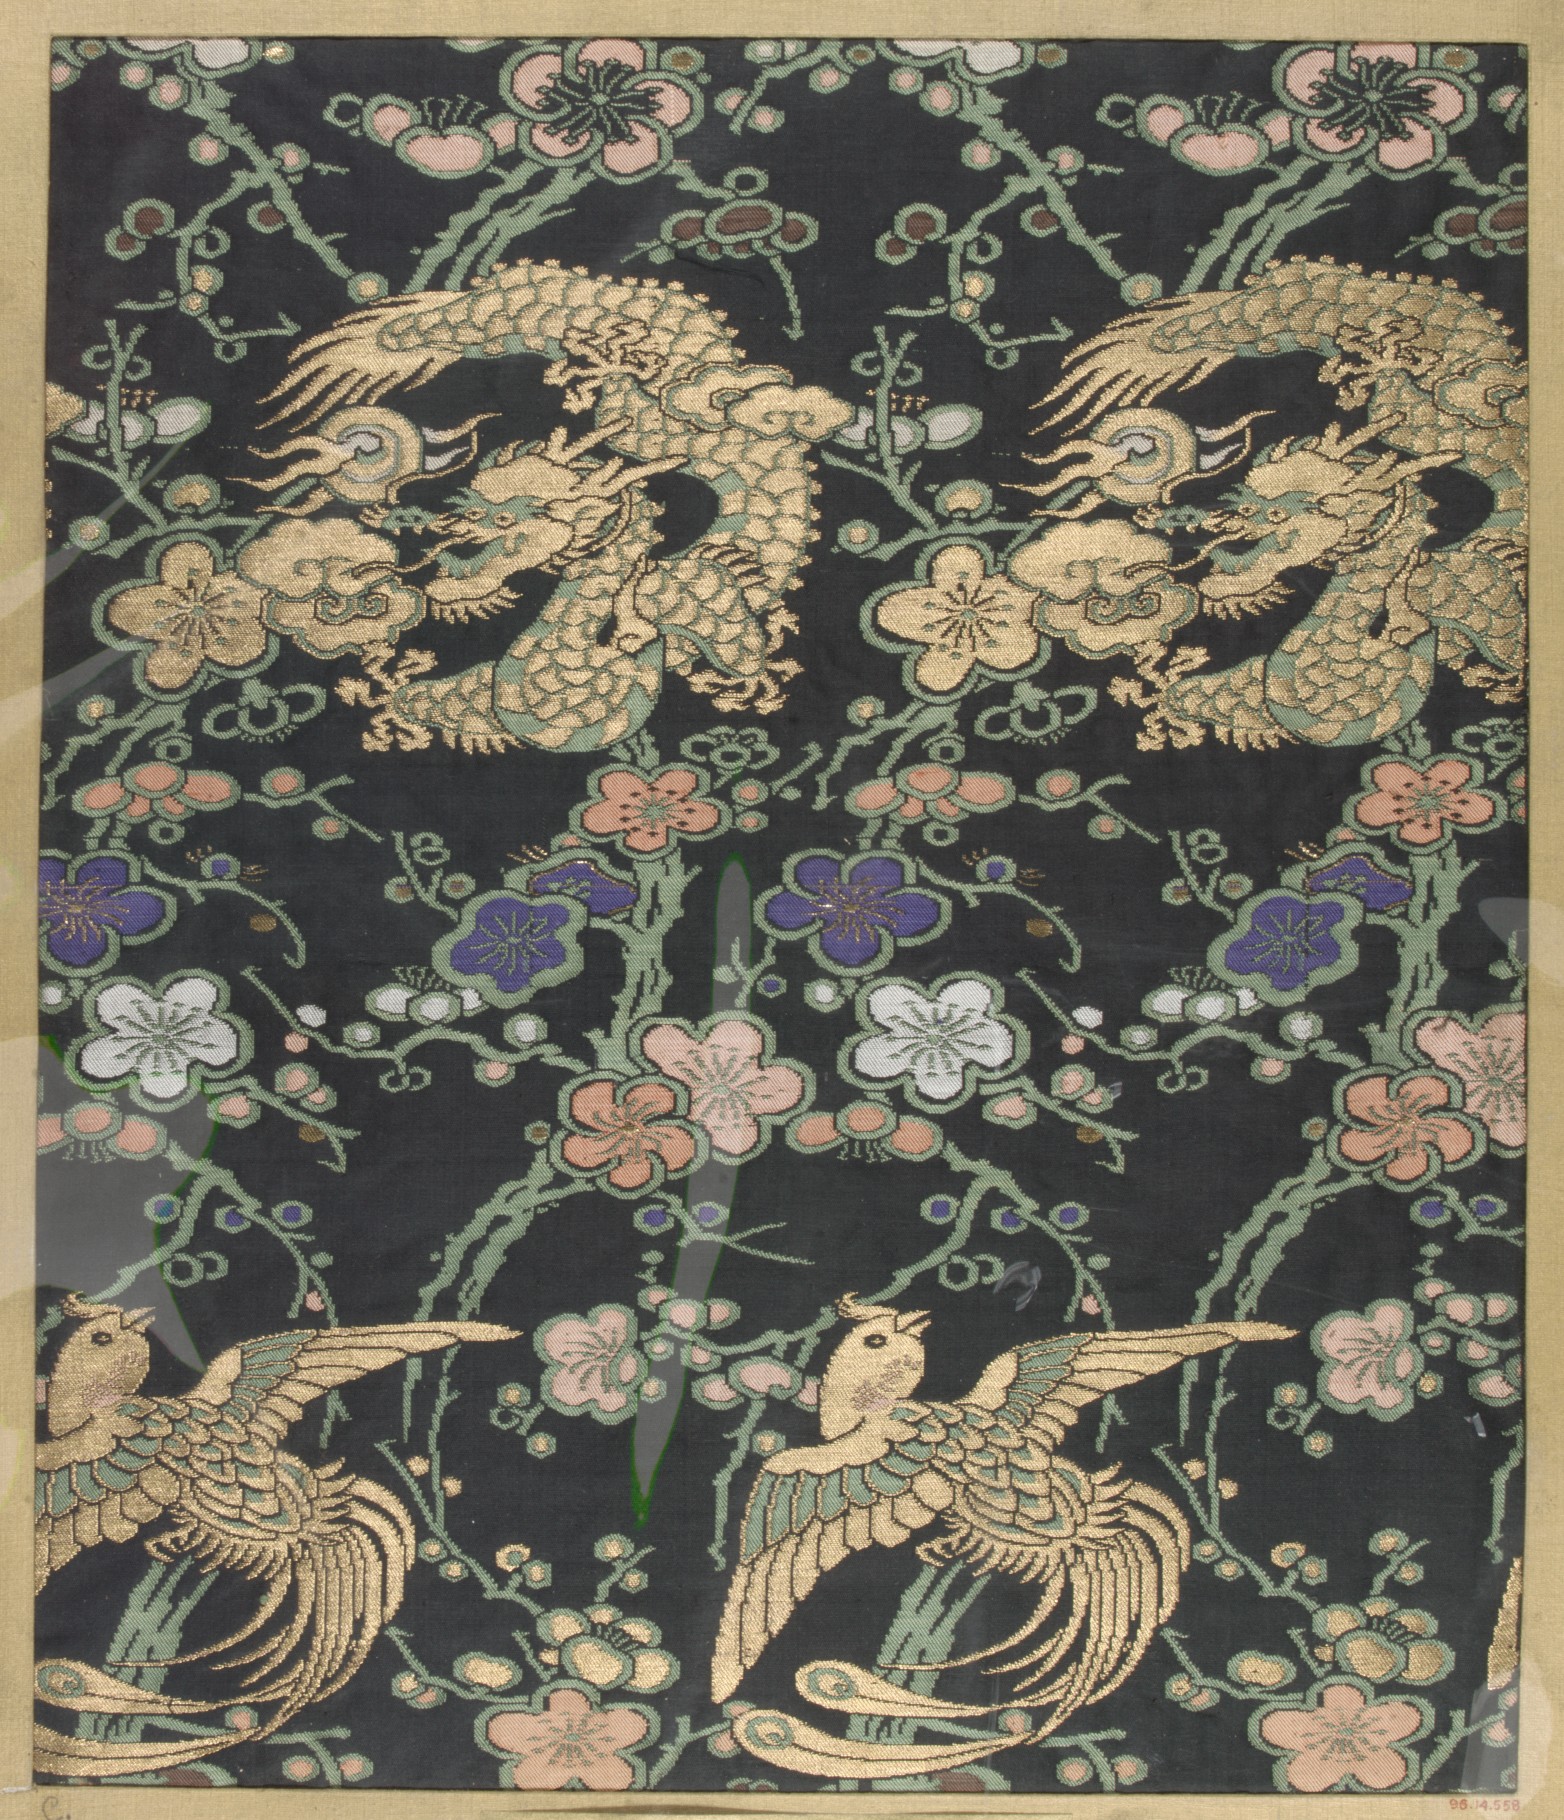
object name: piece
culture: japanese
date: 1701-1900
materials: silk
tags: birds,flowers